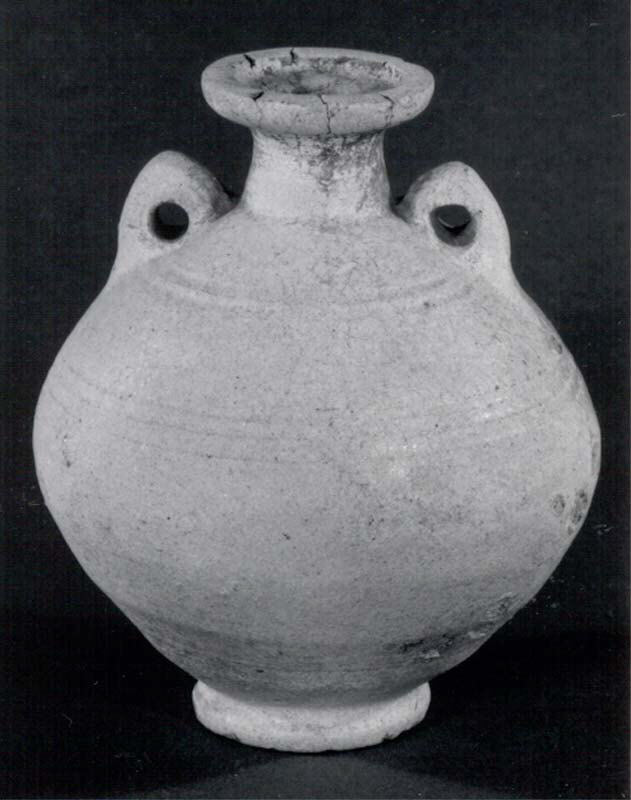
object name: vessel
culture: parthian or seleucid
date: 201-300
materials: ceramic, glaze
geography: mesopotamia